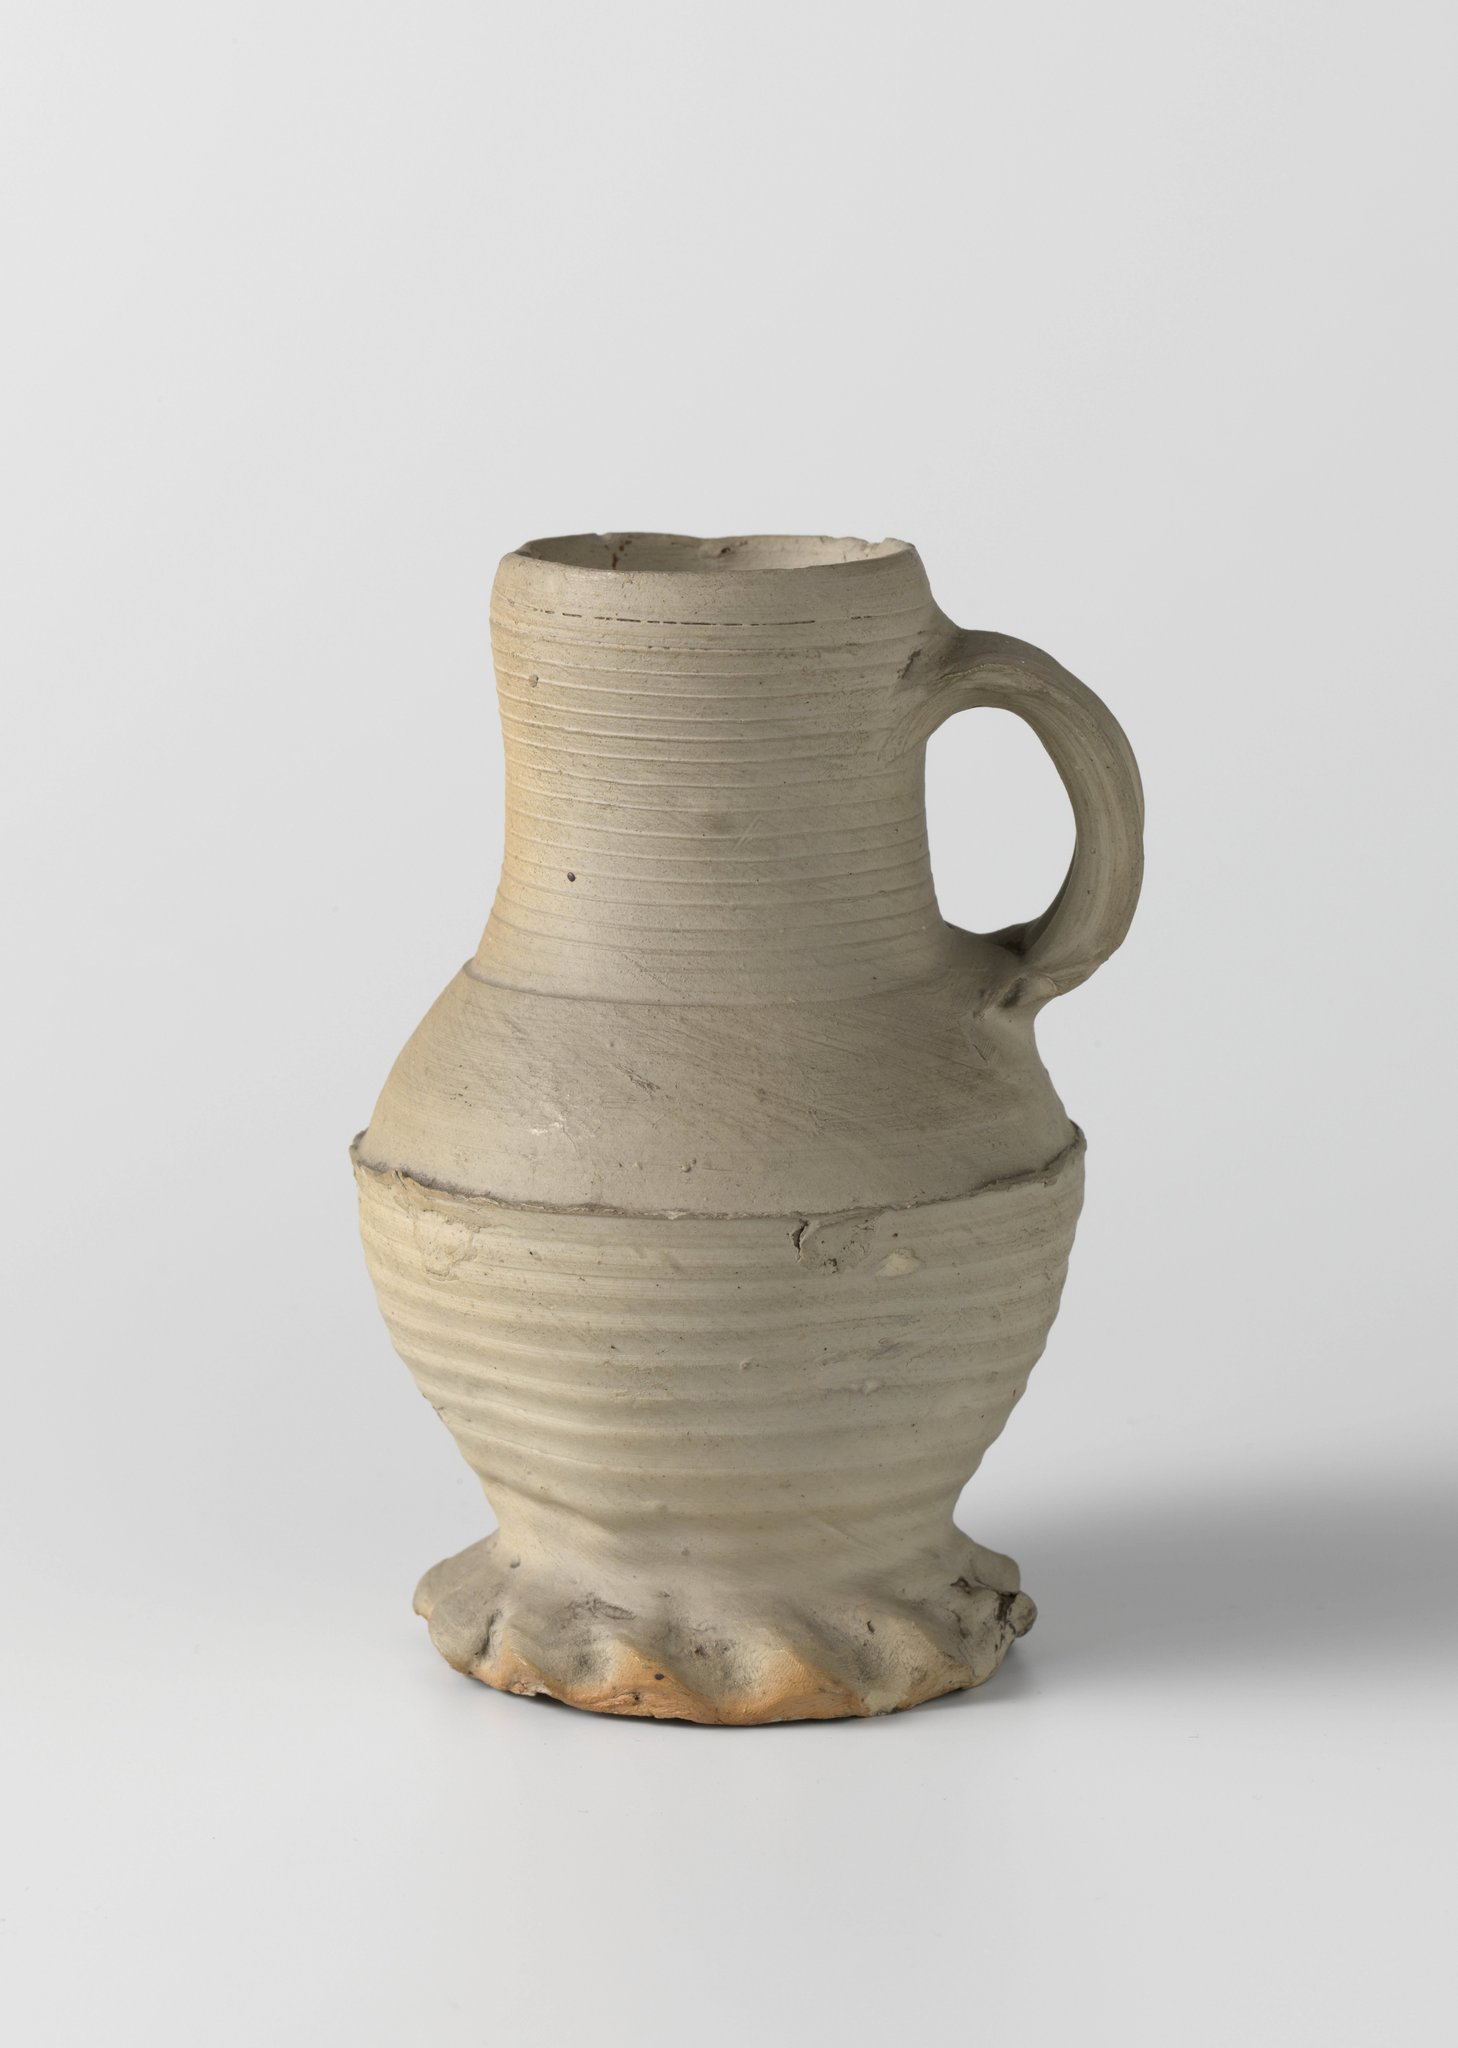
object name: jug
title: Jug with rilling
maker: Anonymous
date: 1400-1599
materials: glaze, stoneware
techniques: firing, forming, turning, vitrification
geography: germany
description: Kruik van steengoed op golvende voet met een eivormig lichaam en wijde nek. Het C-vormige oor is bevestigd aan de nek en de schouder. De kruik is versierd met draairingen, waarbij de schouder is gladgestreken en er een profiel is ontstaan op de buik.